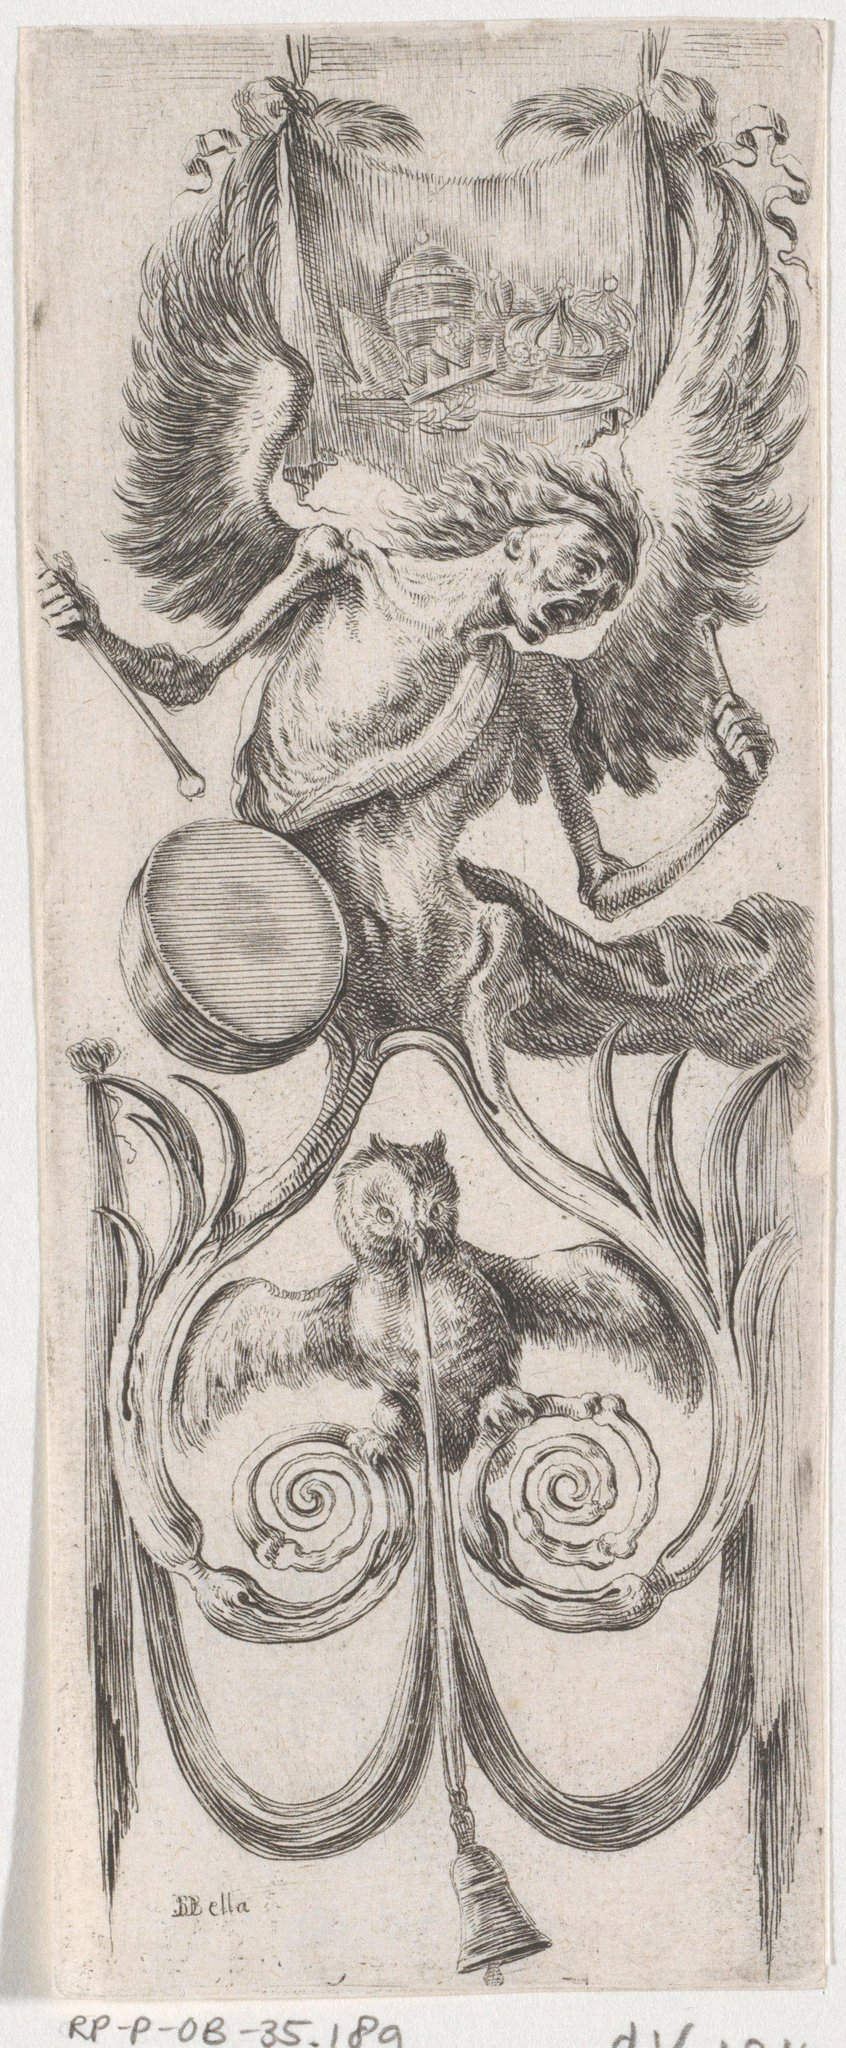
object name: print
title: Ornament met de Dood en een uil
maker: stefano della bella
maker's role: draughtsman, print maker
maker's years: 1610-1664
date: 1620-1664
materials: paper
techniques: etching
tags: death as skeleton, owls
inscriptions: collector's mark: Lugt 240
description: Een ornament met de Dood slaand op een trommel. Tussen zijn vleugels is een doek gespannen met een voorstelling van kronen. Onder een uil met een lint in zijn bek waar een bel aan hangt.